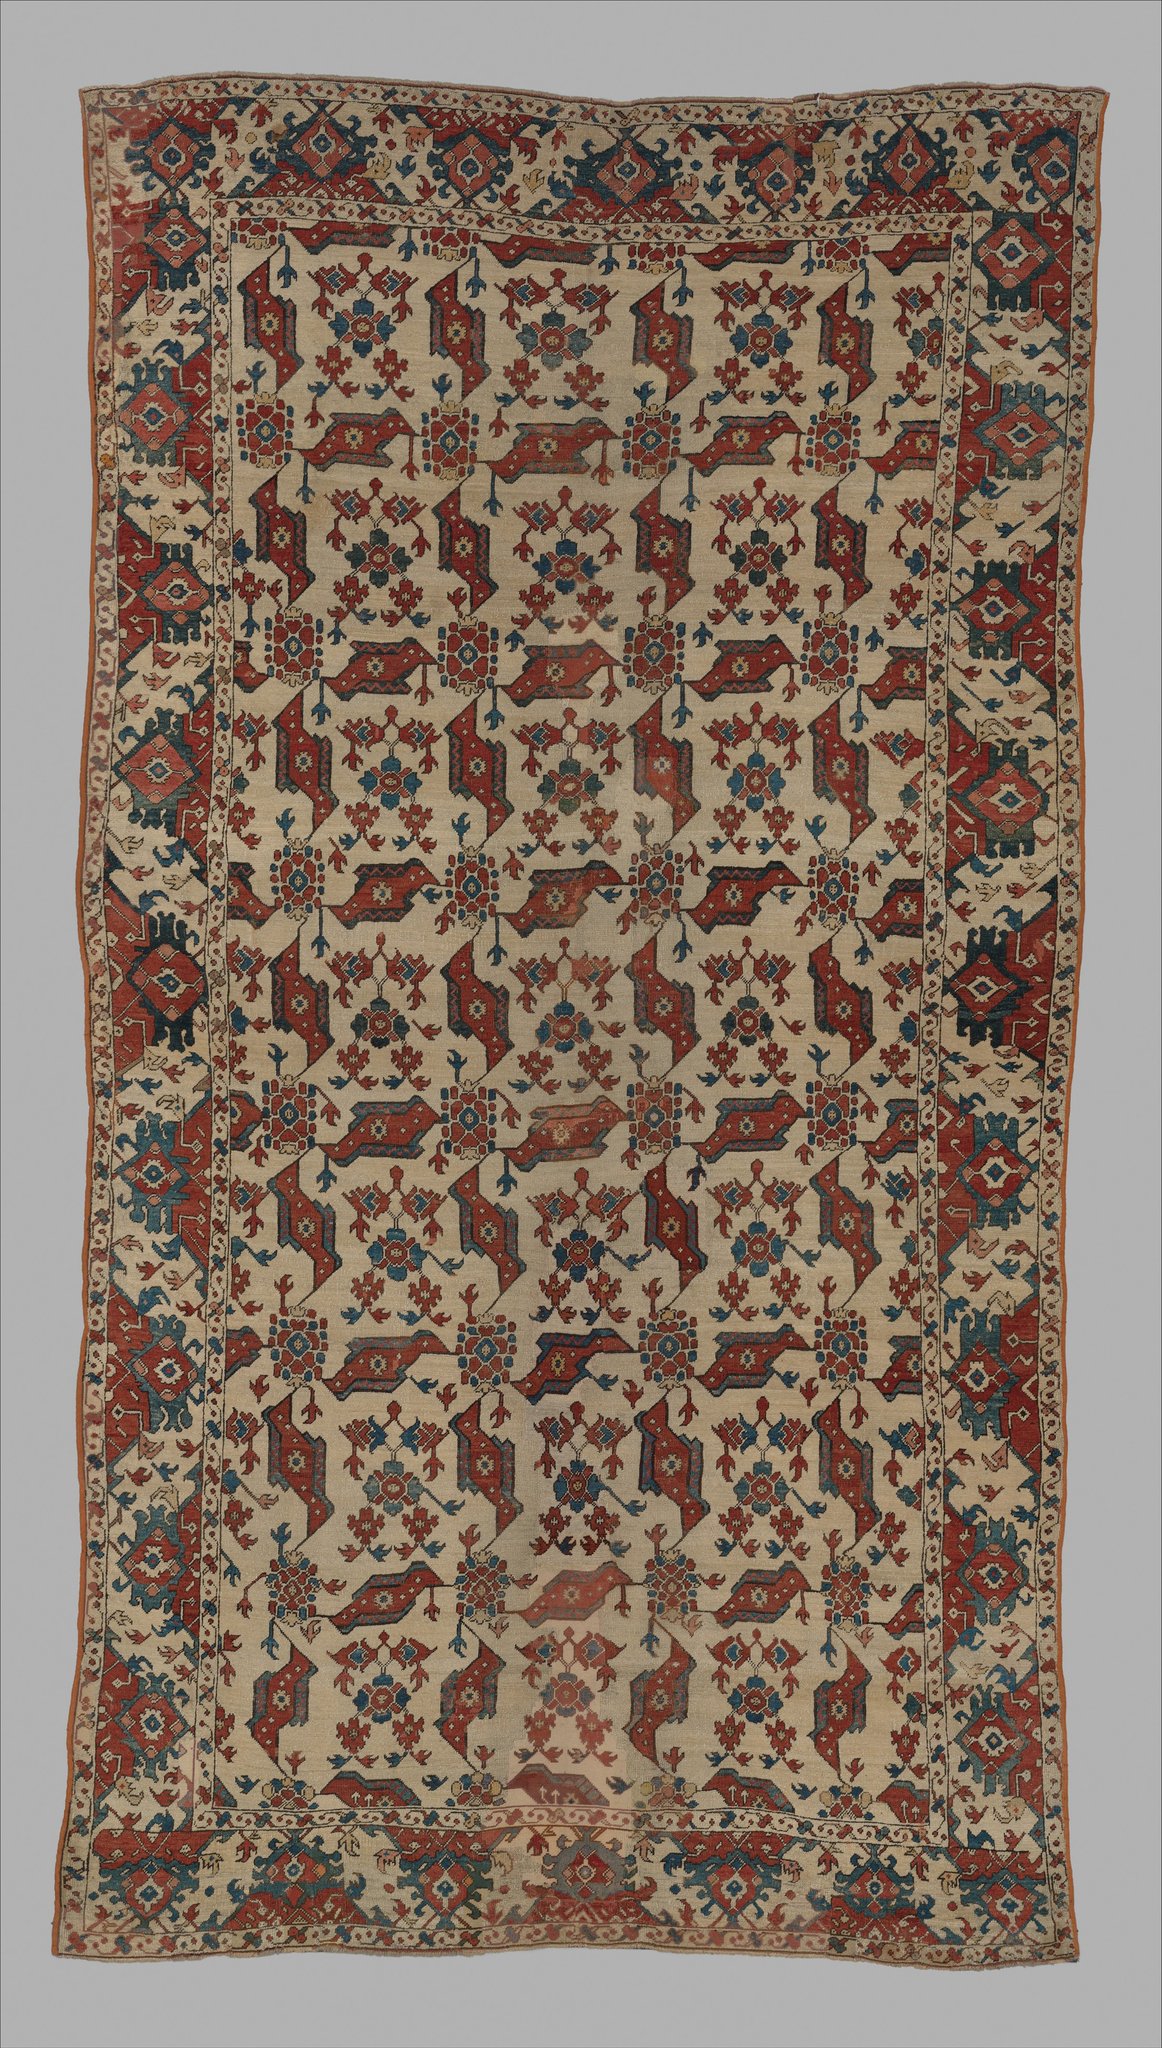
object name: carpet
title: "Bird" Carpet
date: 1601-1700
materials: wool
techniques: pile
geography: turkey